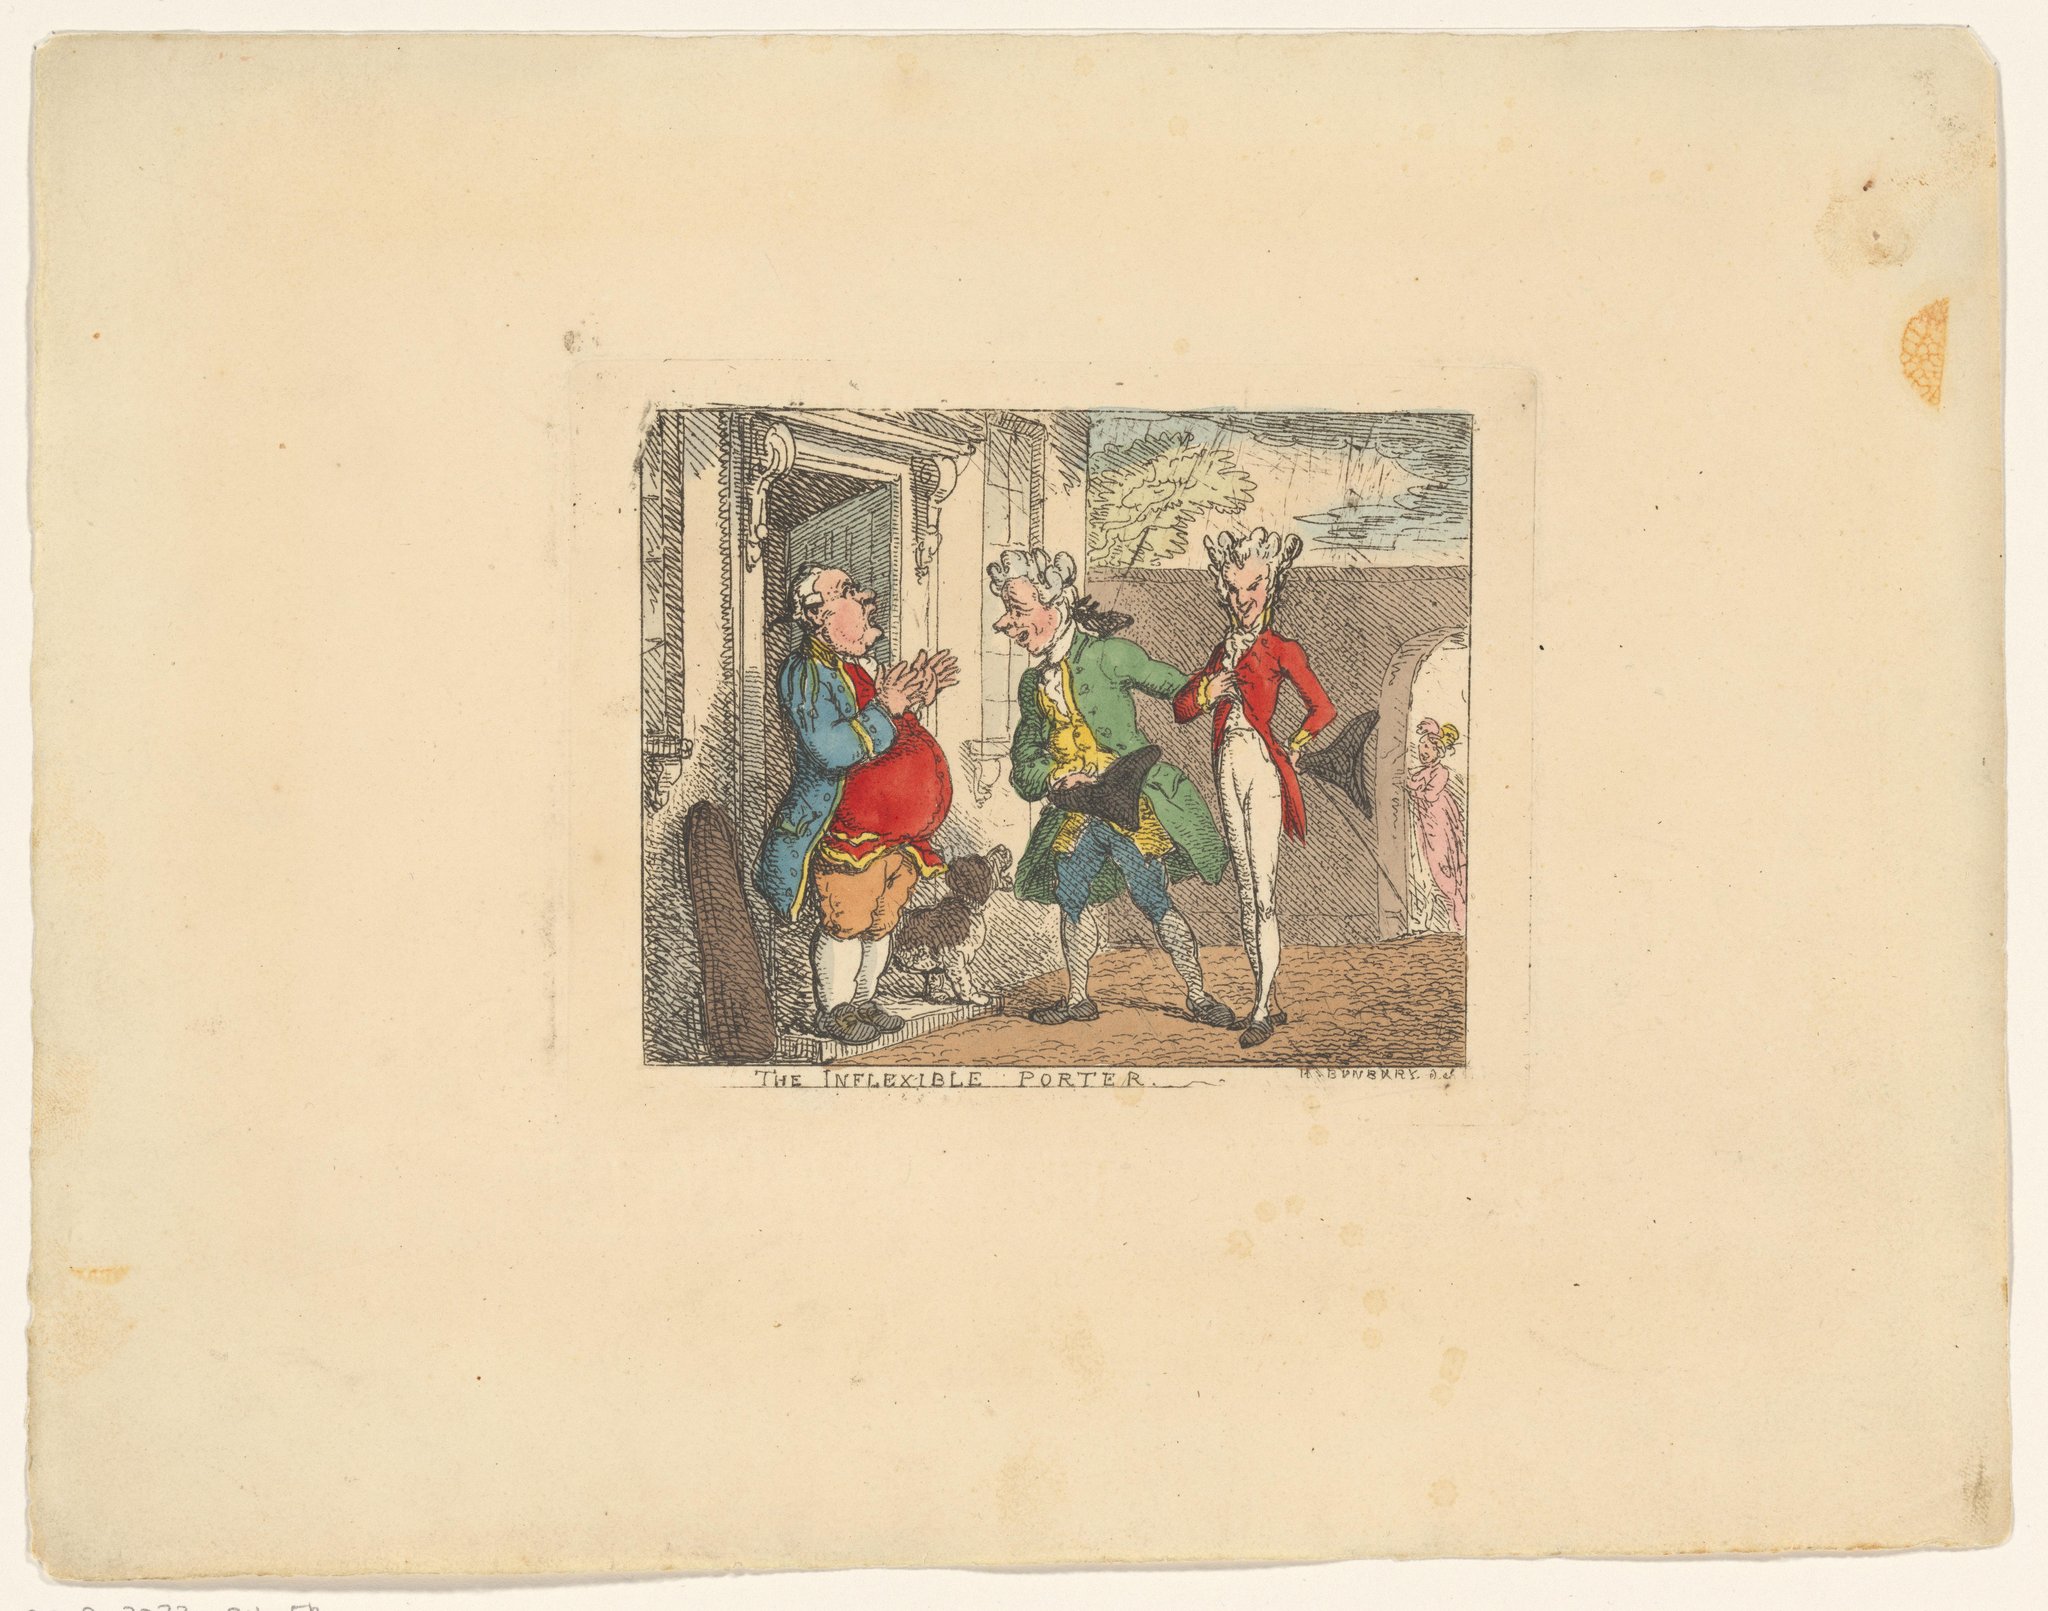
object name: cartoon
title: The Inflexible Porter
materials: paper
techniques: etching, hand coloring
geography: london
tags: club, meeting place, caricatures (human types)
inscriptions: collector's mark: Lugt 2228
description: Twee goedgeklede mannen worden geweerd door een portier.